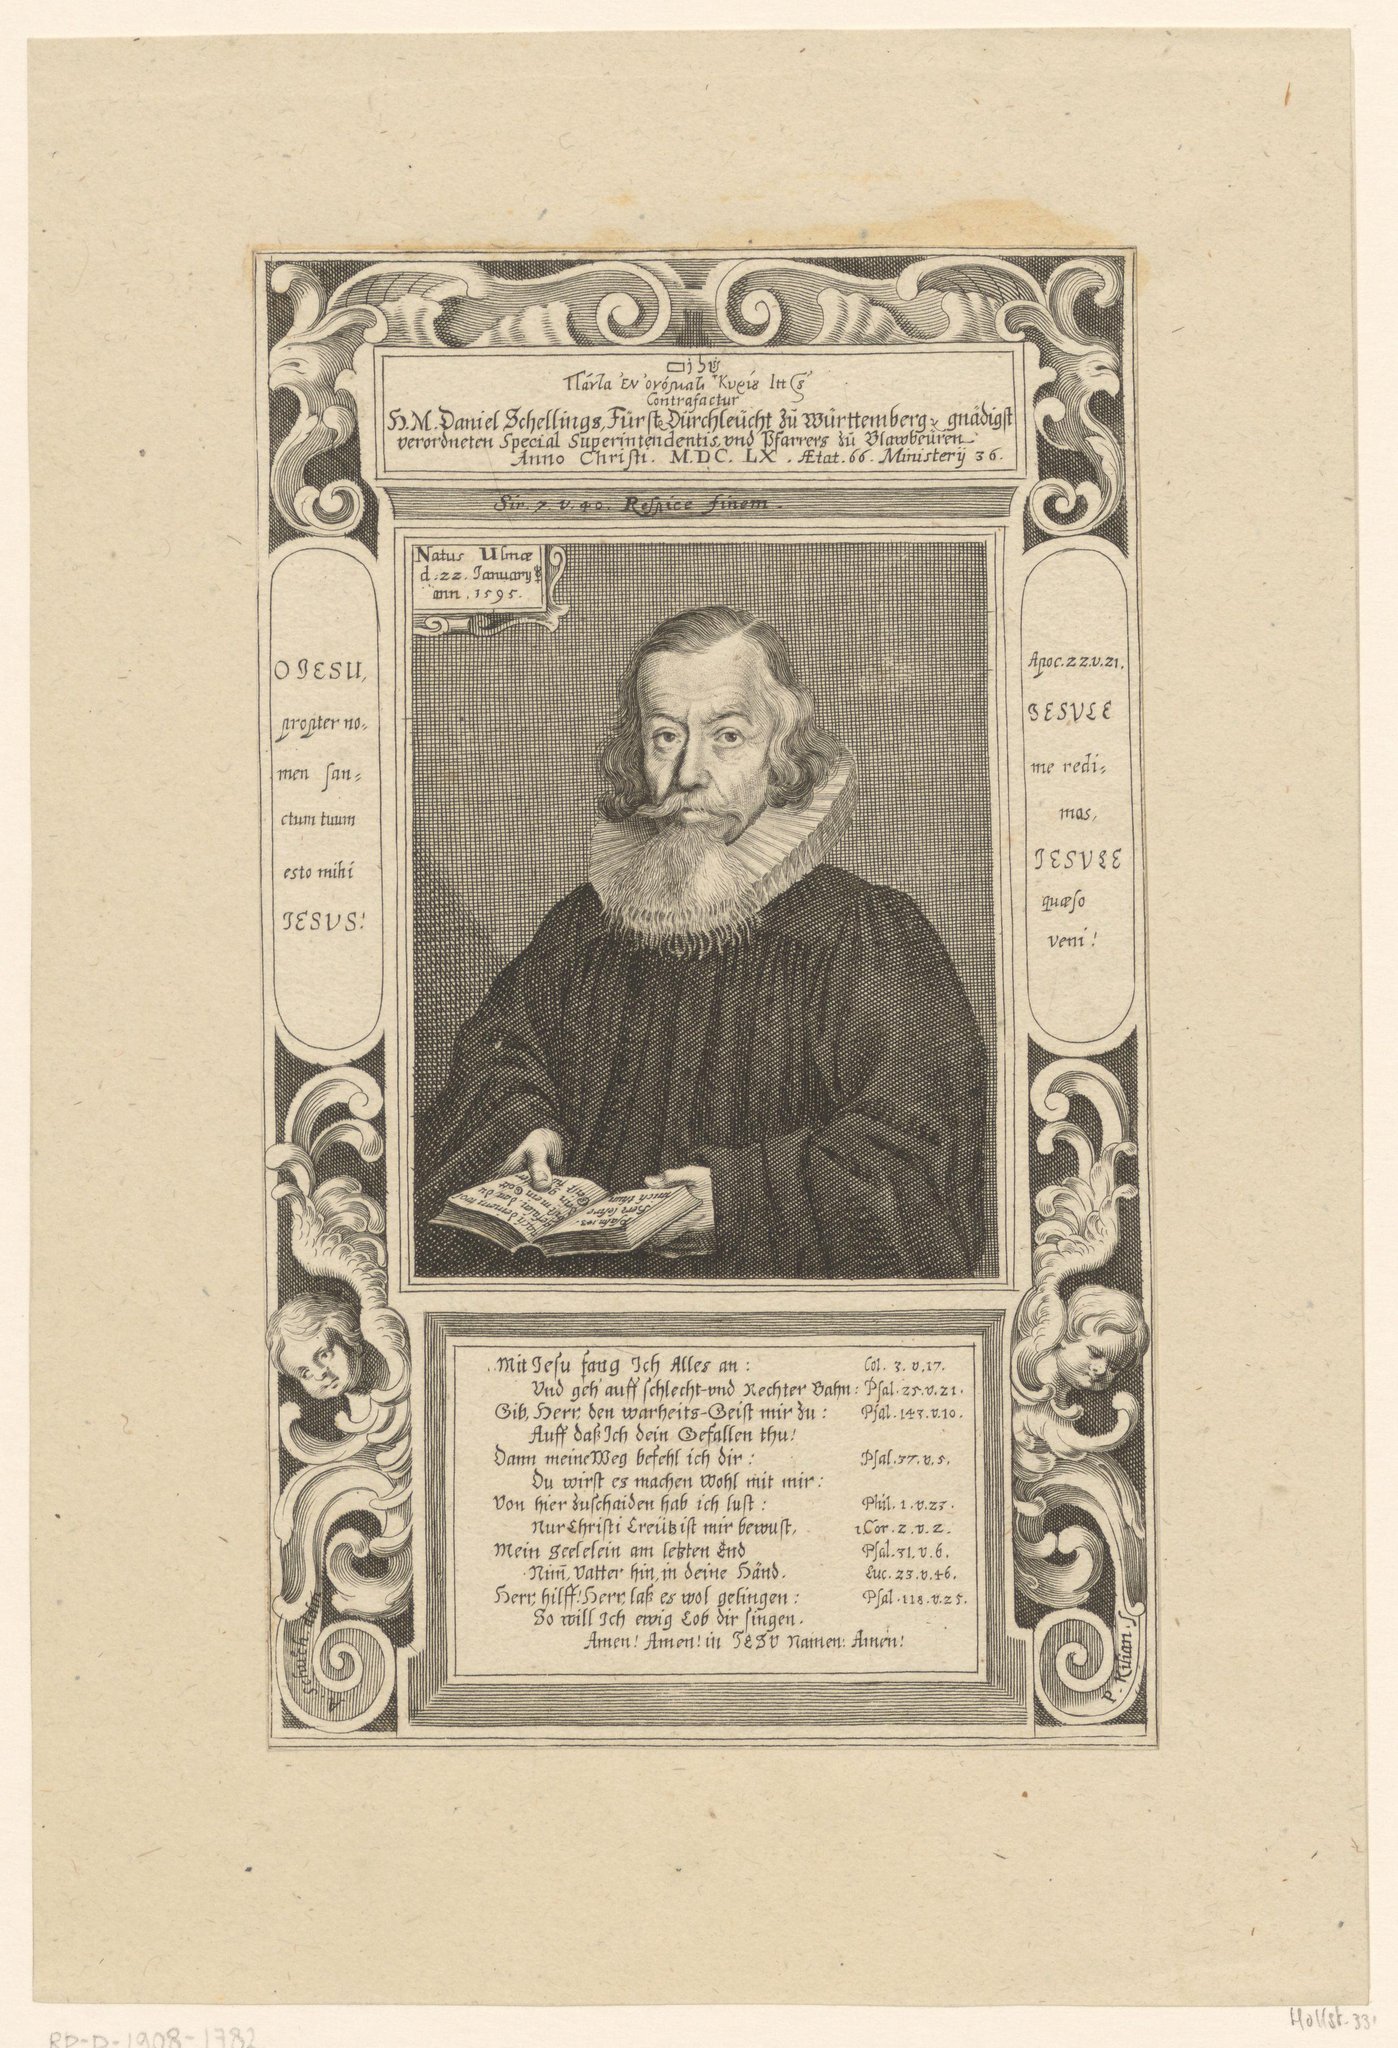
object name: print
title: Portret van Daniel Schelling op 66-jarige leeftijd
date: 1660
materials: paper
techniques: engraving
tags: theologian, historical persons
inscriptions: collector's mark: Lugt 2228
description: Kaders met tekst in het Duits over geportretteerde, en regels uit psalmen en andere Bijbelteksten in het Duits en Latijn in de kaders in de marges met rolwerk en engelenkoppen.